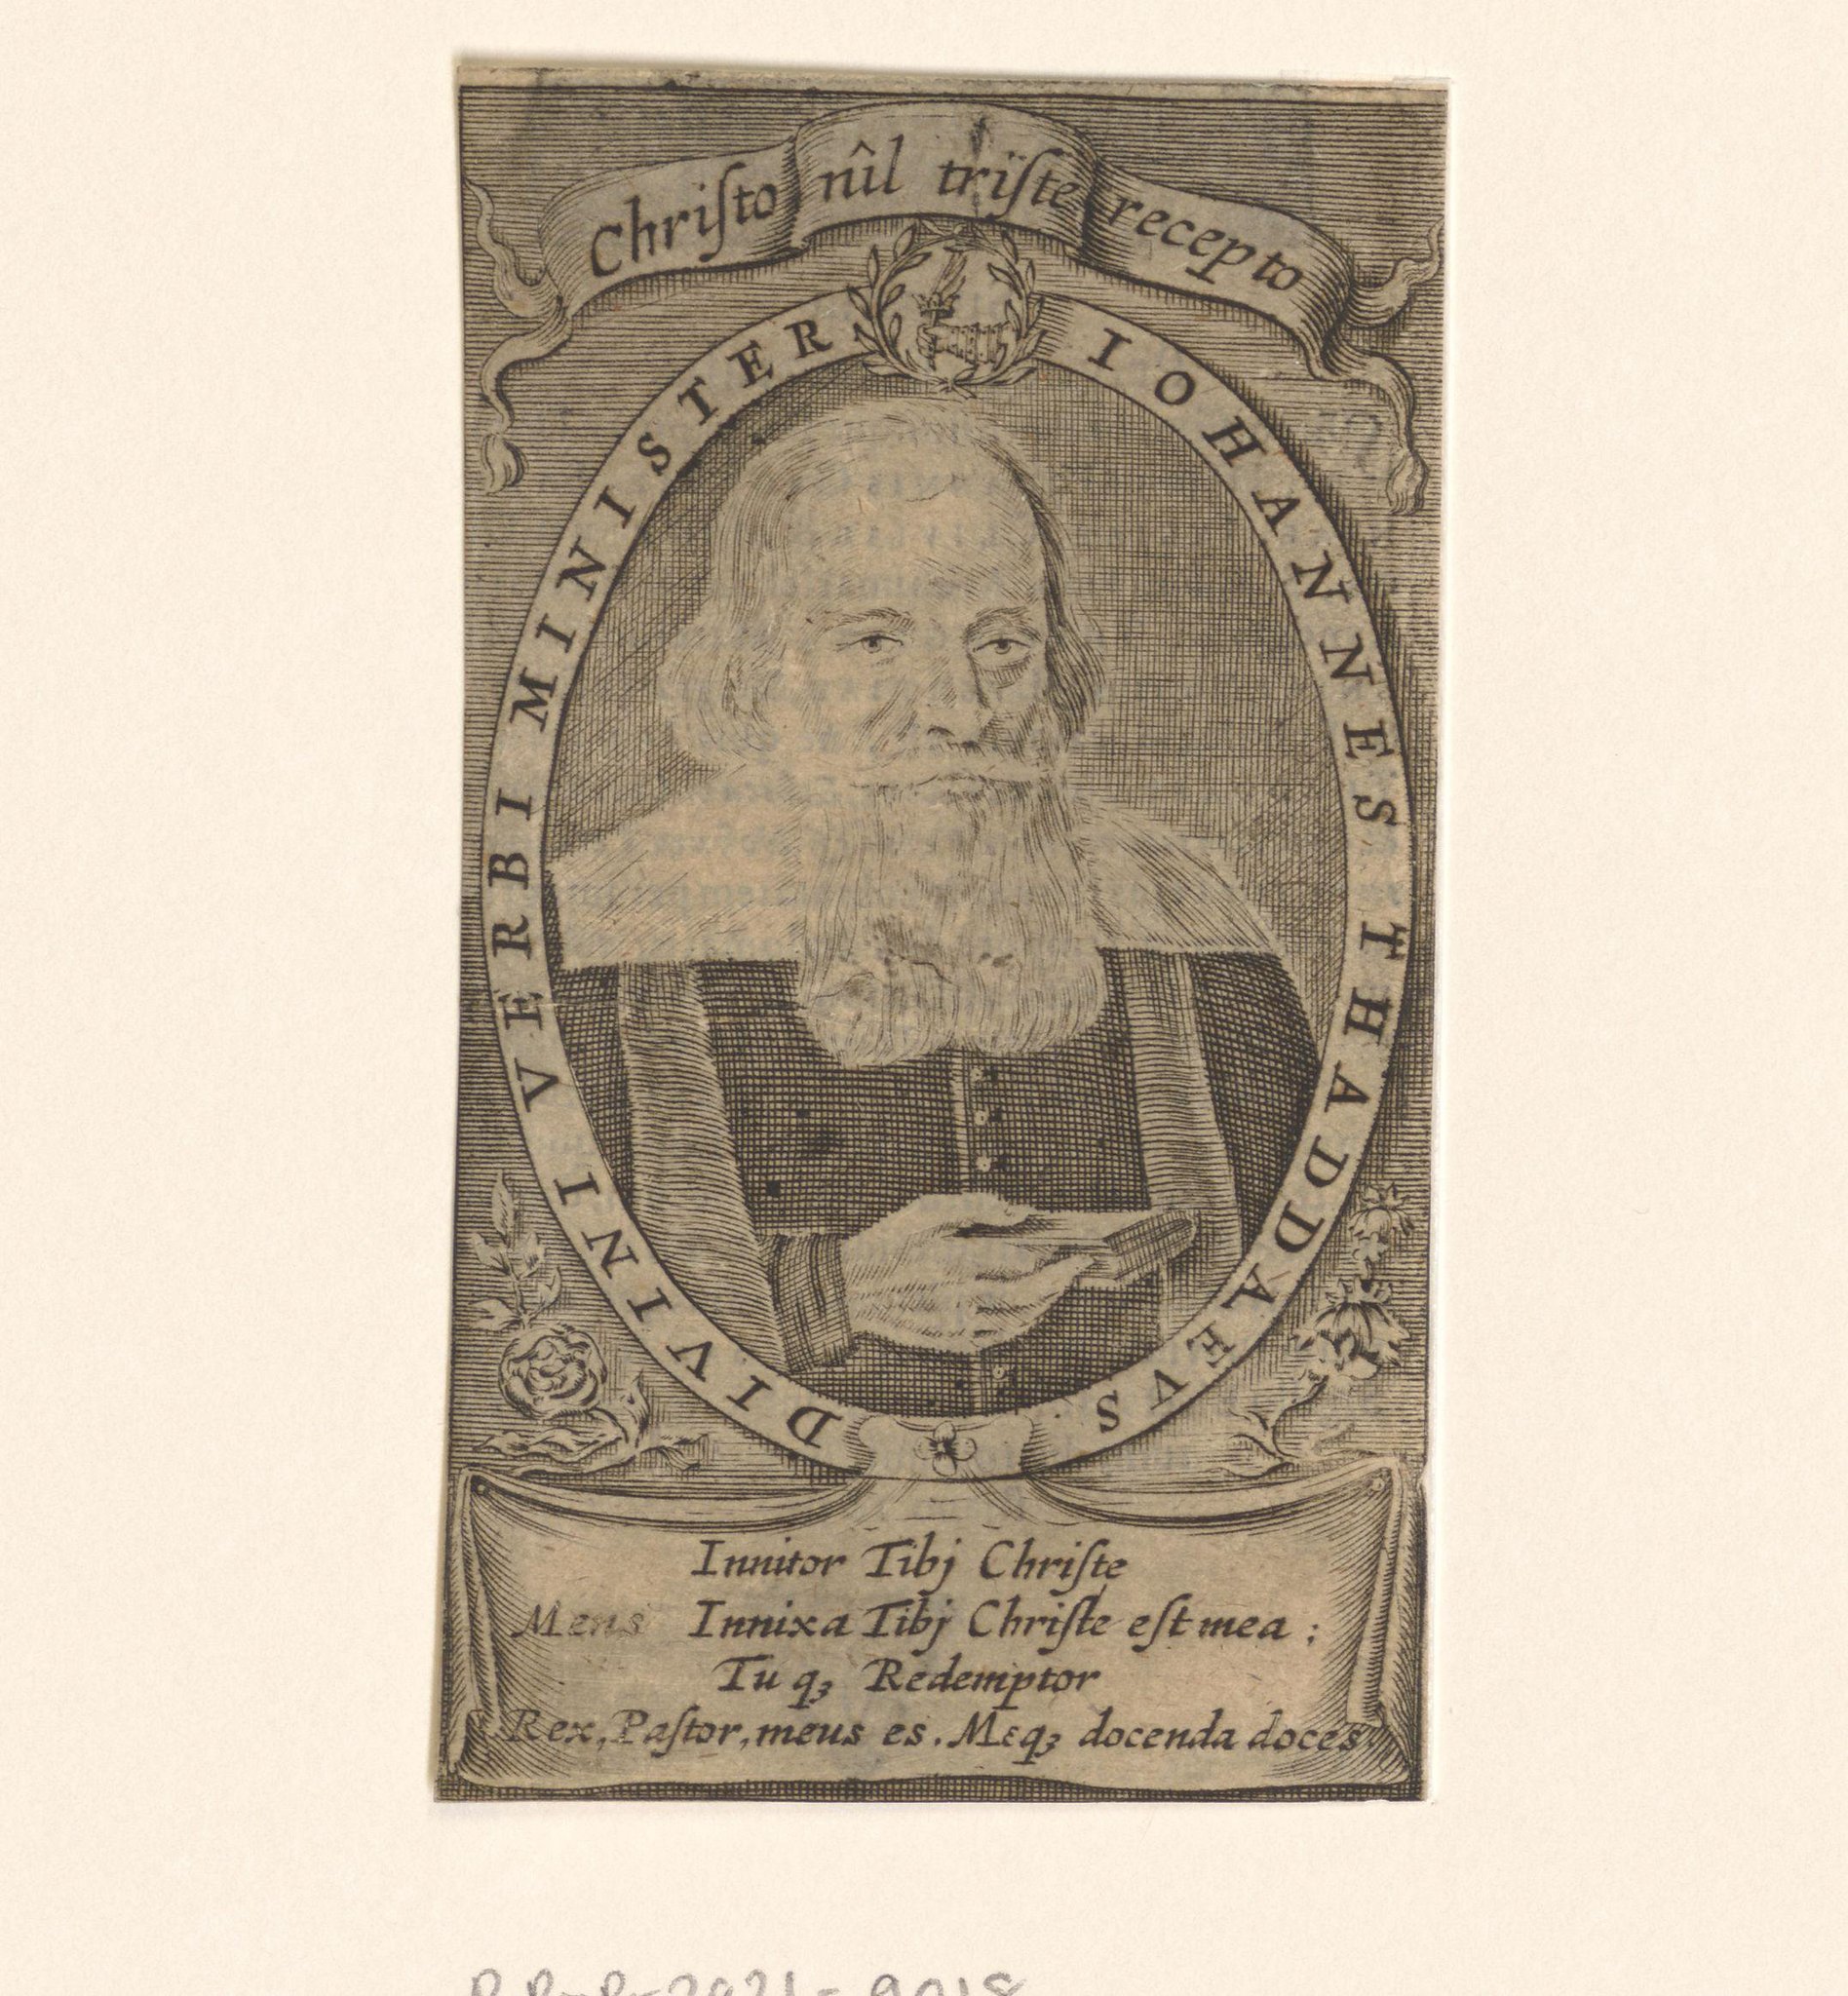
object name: book illustration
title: Portret van Johannes Thaddaeus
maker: Anonymous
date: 1648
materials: paper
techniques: engraving, letterpress printing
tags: historical persons, functionaries and dignitaries ~ episcopal protestant churches, book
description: Prent zonder tekst op verso in: Thaddaeus, Johannes. Conciljatorium biblicum. Amsterdam: Johannes Pauli, 1648.